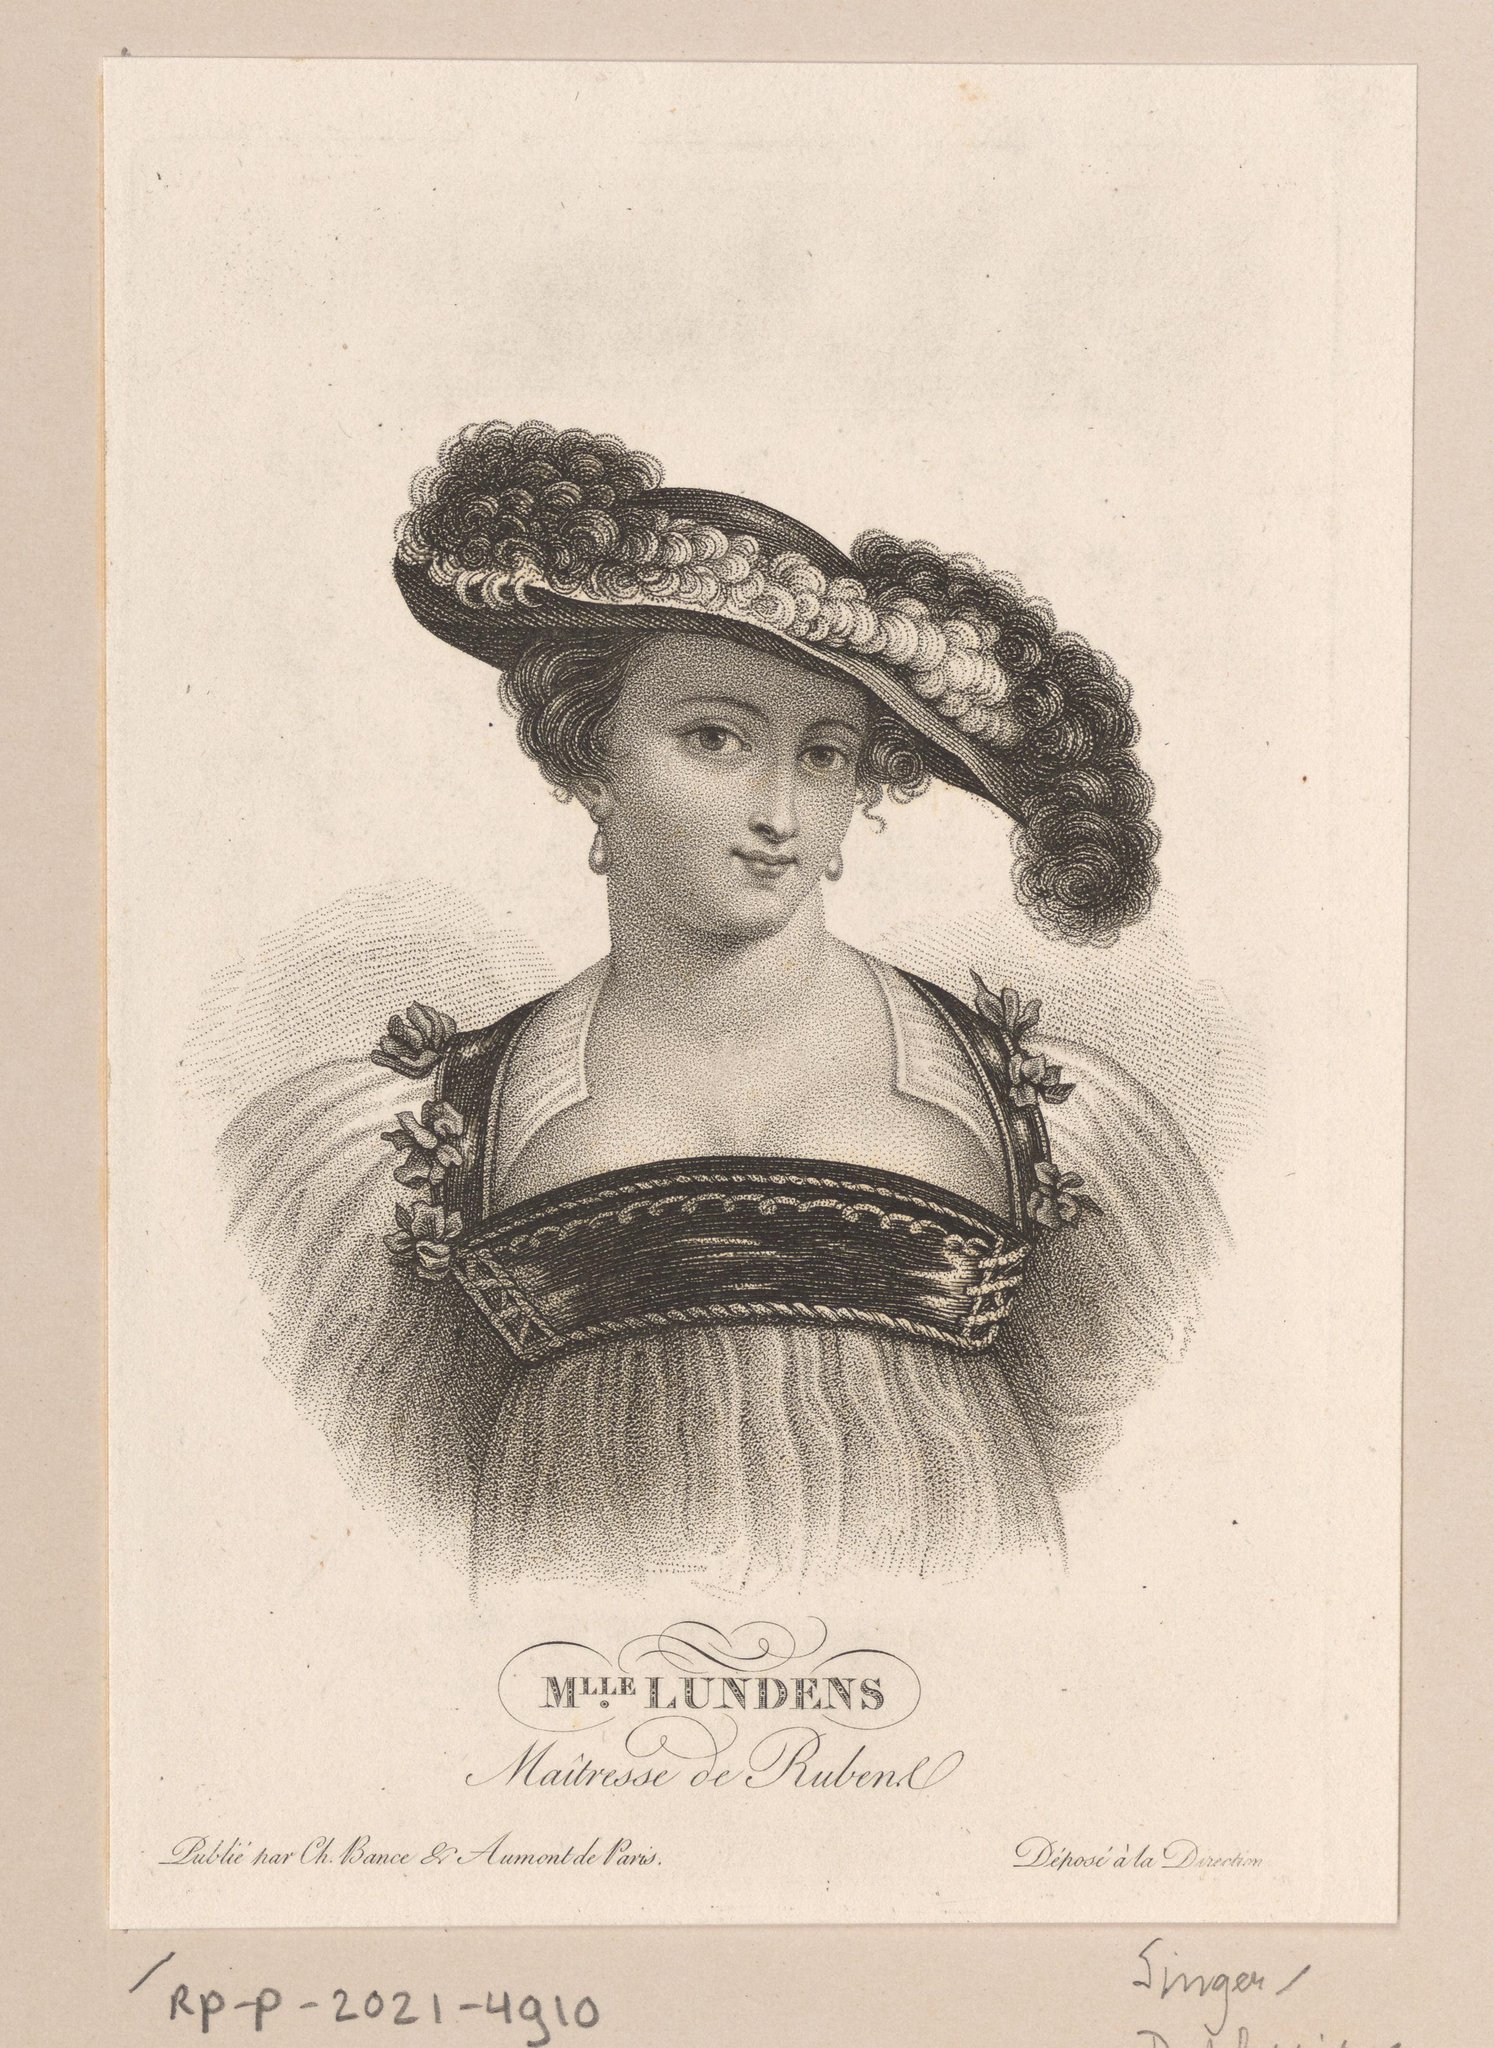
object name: print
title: Mlle. Lundens Maîtresse de Ruben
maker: Anonymous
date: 1811-1824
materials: paper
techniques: engraving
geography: france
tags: historical persons - bb - woman, head-gear: hat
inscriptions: : ‘Déposé à la Direction’